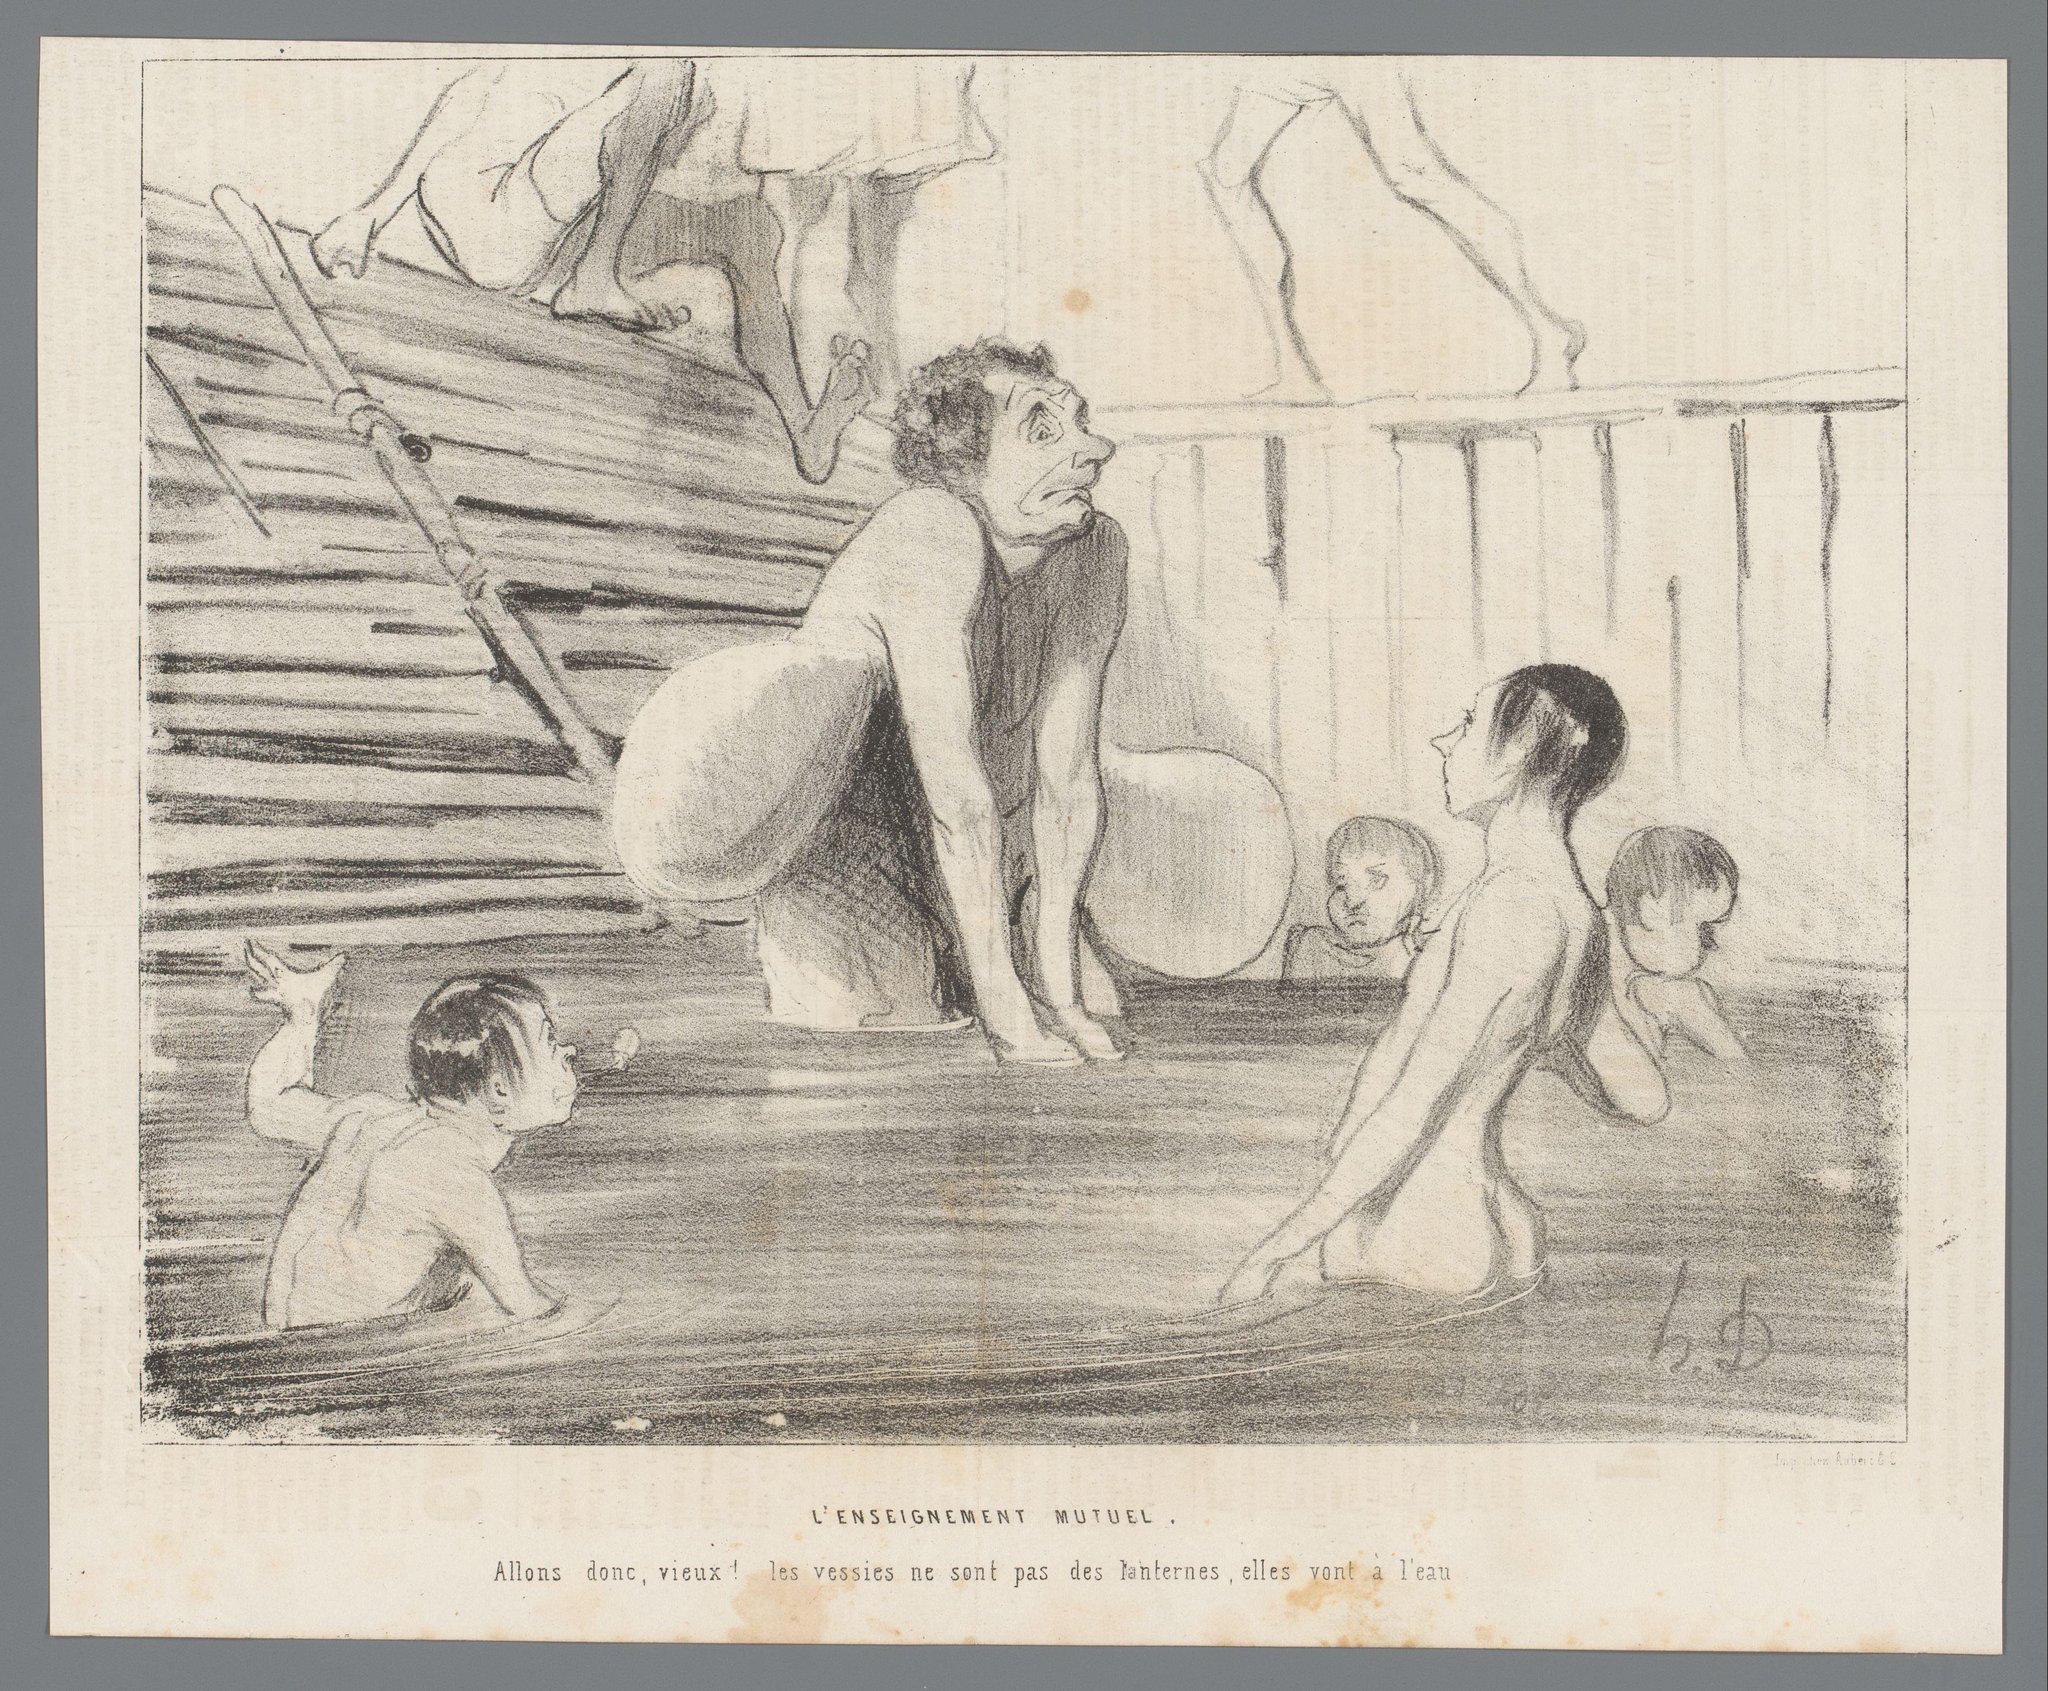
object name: print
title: L'enseignement mutuel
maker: honoré daumier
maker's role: draughtsman, painter, print maker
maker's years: 1808-1879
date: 1842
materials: paper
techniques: letterpress printing, lithograph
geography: paris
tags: caricatures (human types), swimming (sport)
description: Prent uit: Le Charivari, 29 augustus 1842.